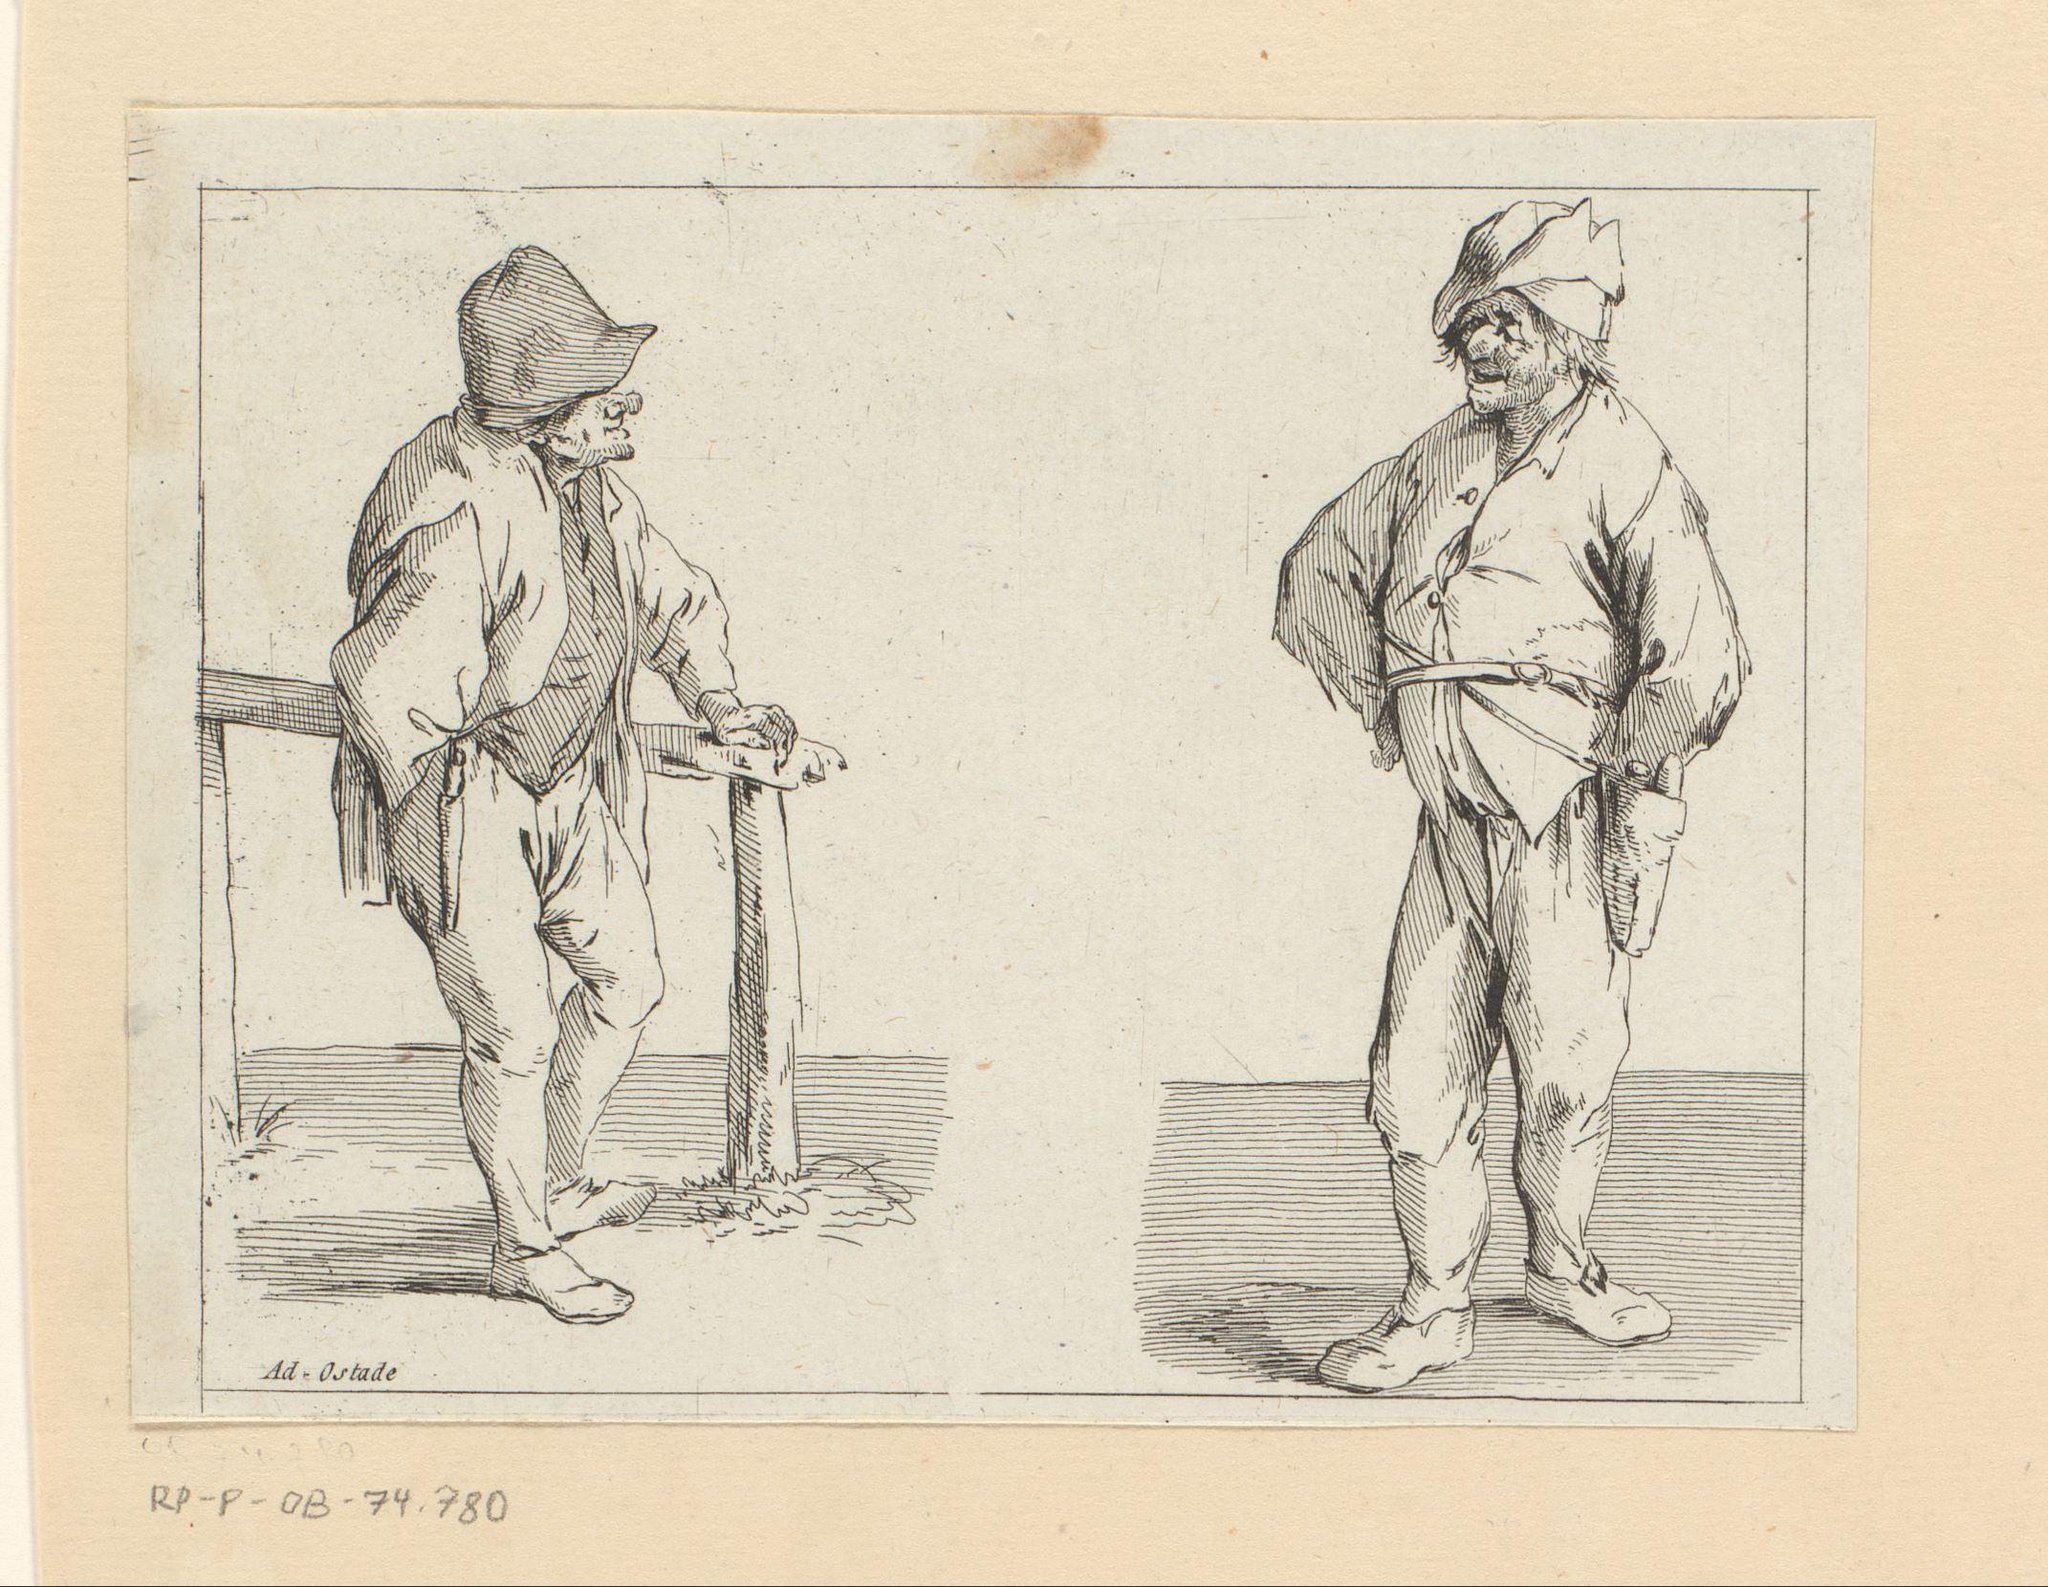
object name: print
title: Twee staande mannen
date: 1700-1730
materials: paper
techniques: etching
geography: france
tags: standing figure, adult man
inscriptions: collector's mark: Lugt 240